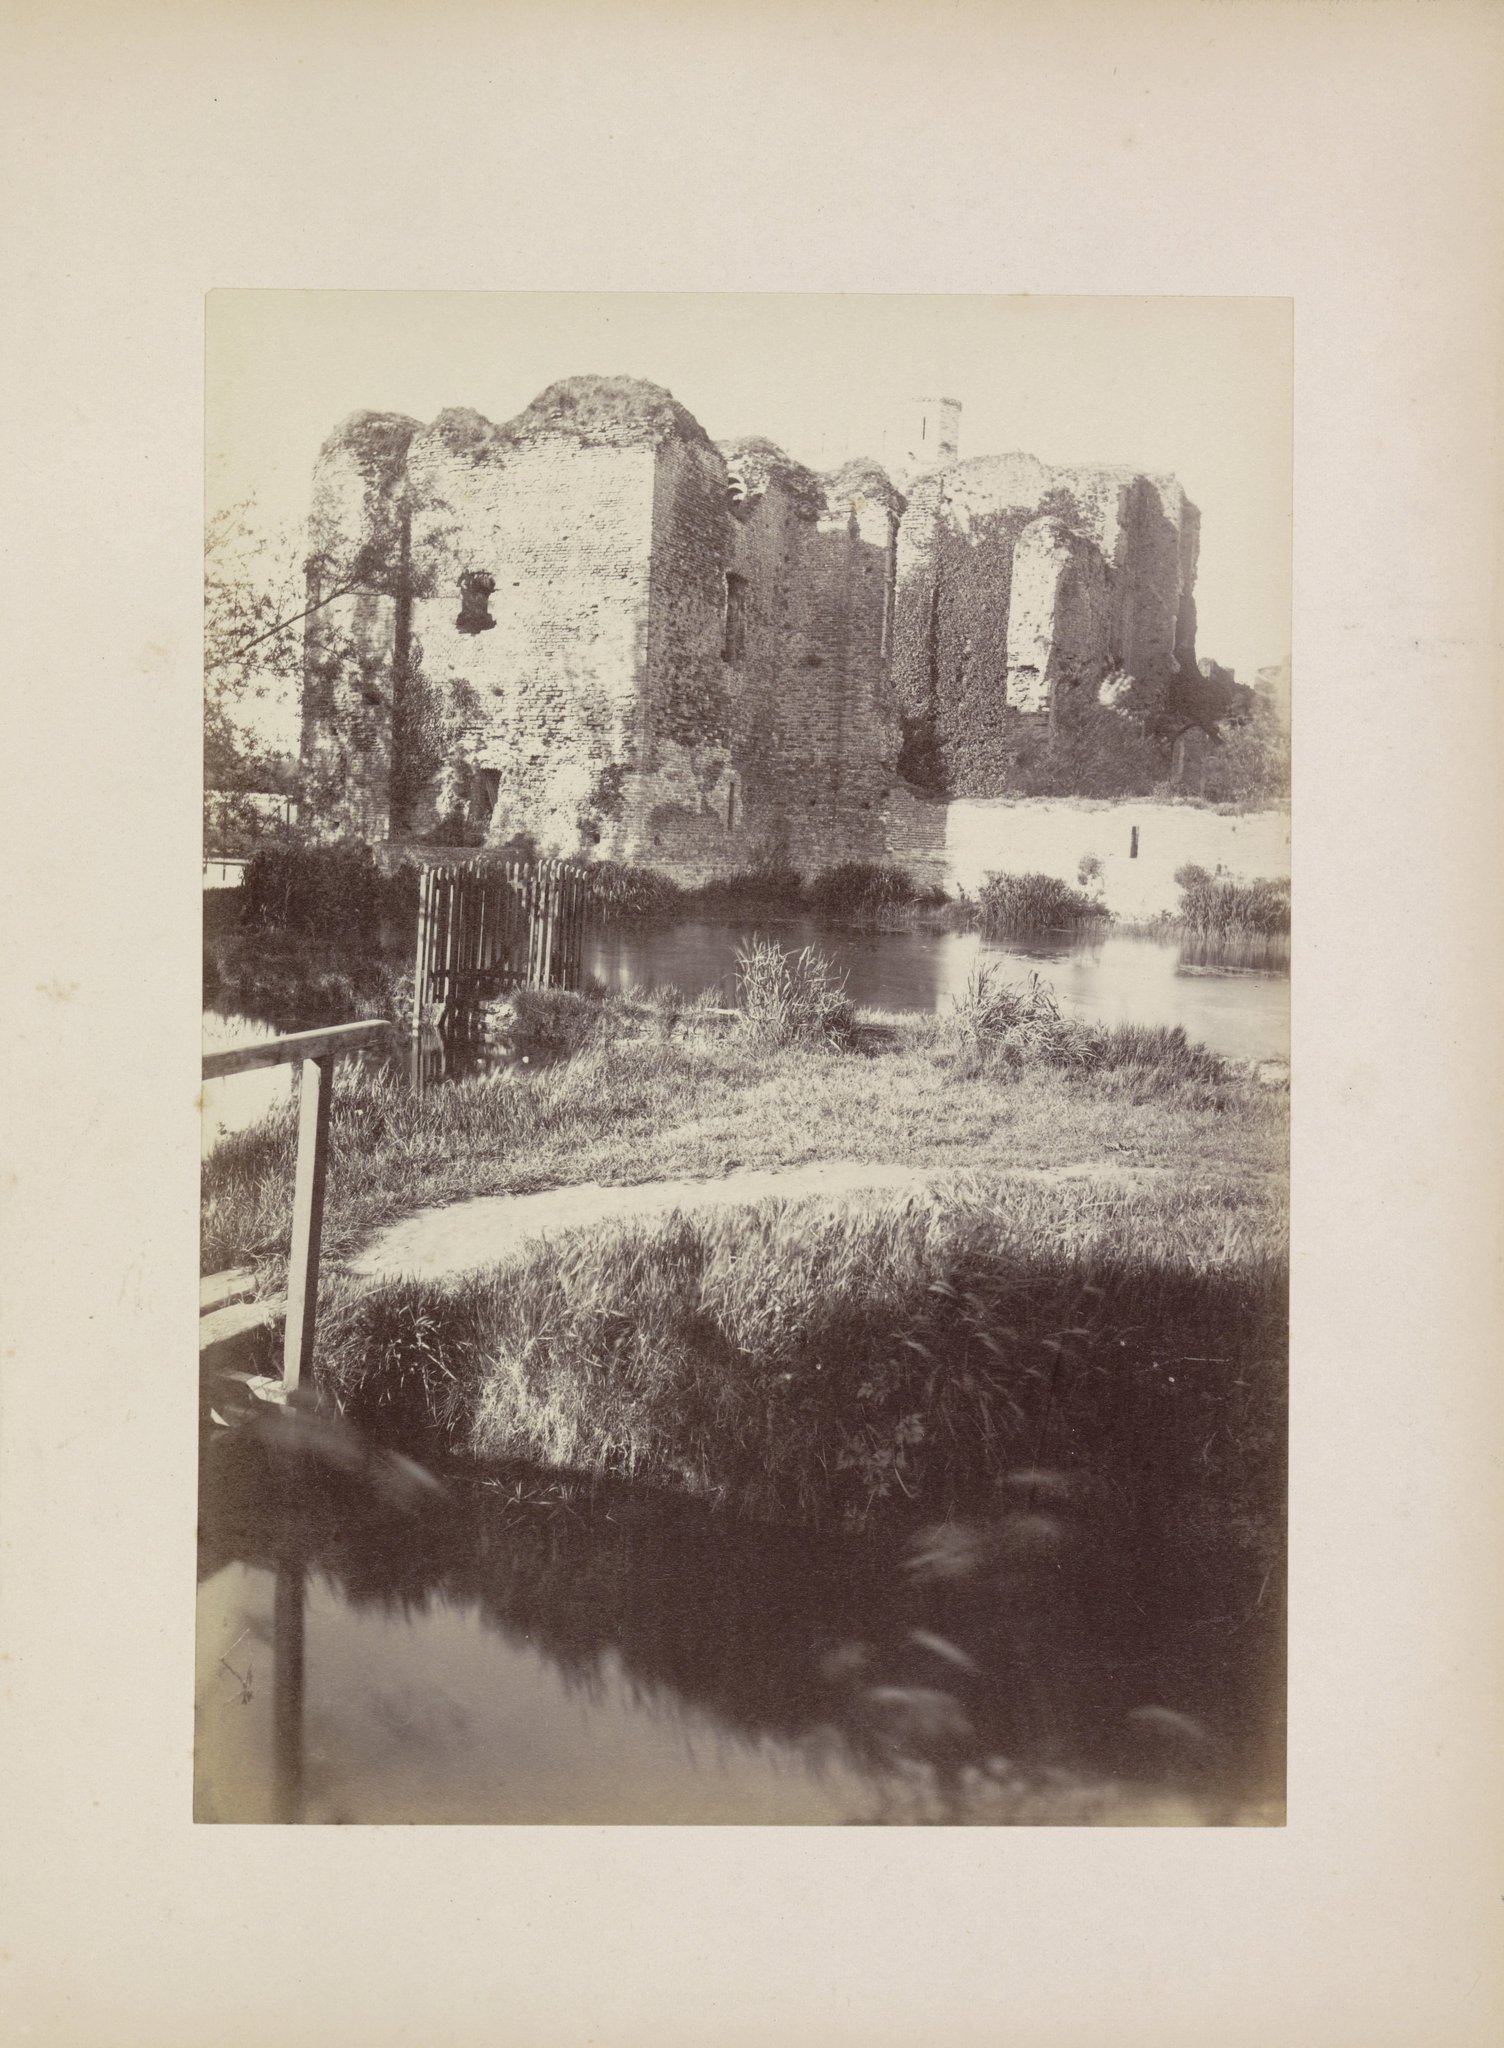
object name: photograph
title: Brederode (chateau de) / Amsterdam (Holande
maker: Anonymous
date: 1885-1900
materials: paper, photographic support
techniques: albumen print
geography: france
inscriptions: annotation: ‘Brederode (chateau de) / Amsterdam (Holande’